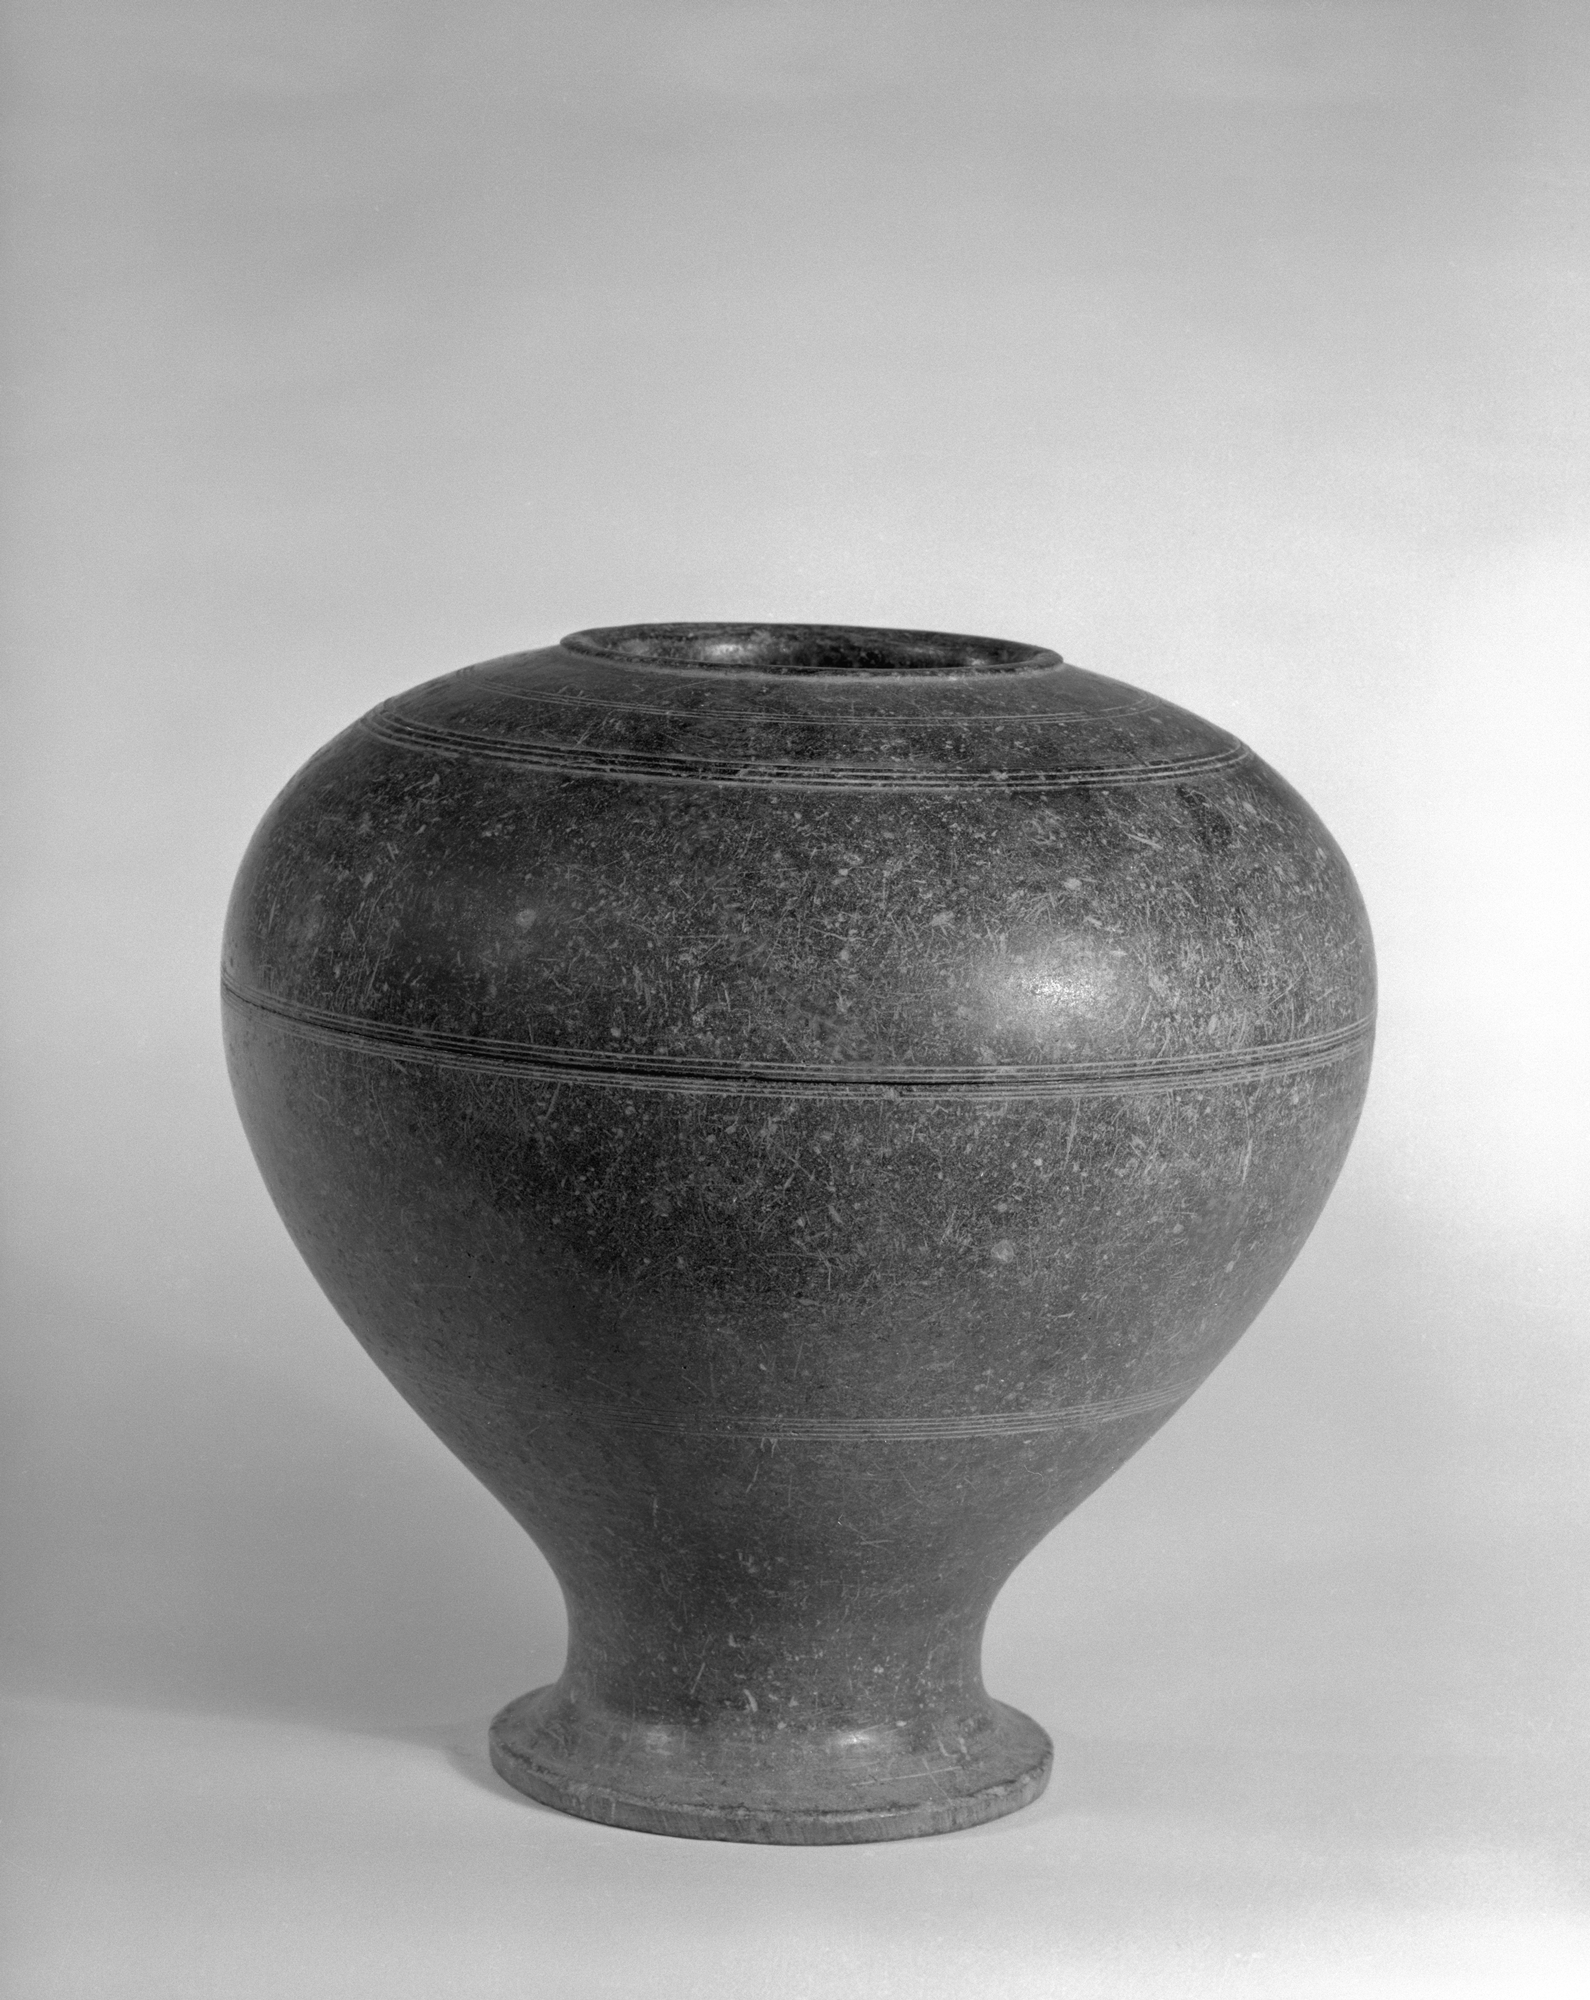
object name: urn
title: Reliquary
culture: gandhara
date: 1-300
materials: gold, quartz, stone, silver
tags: gandhara